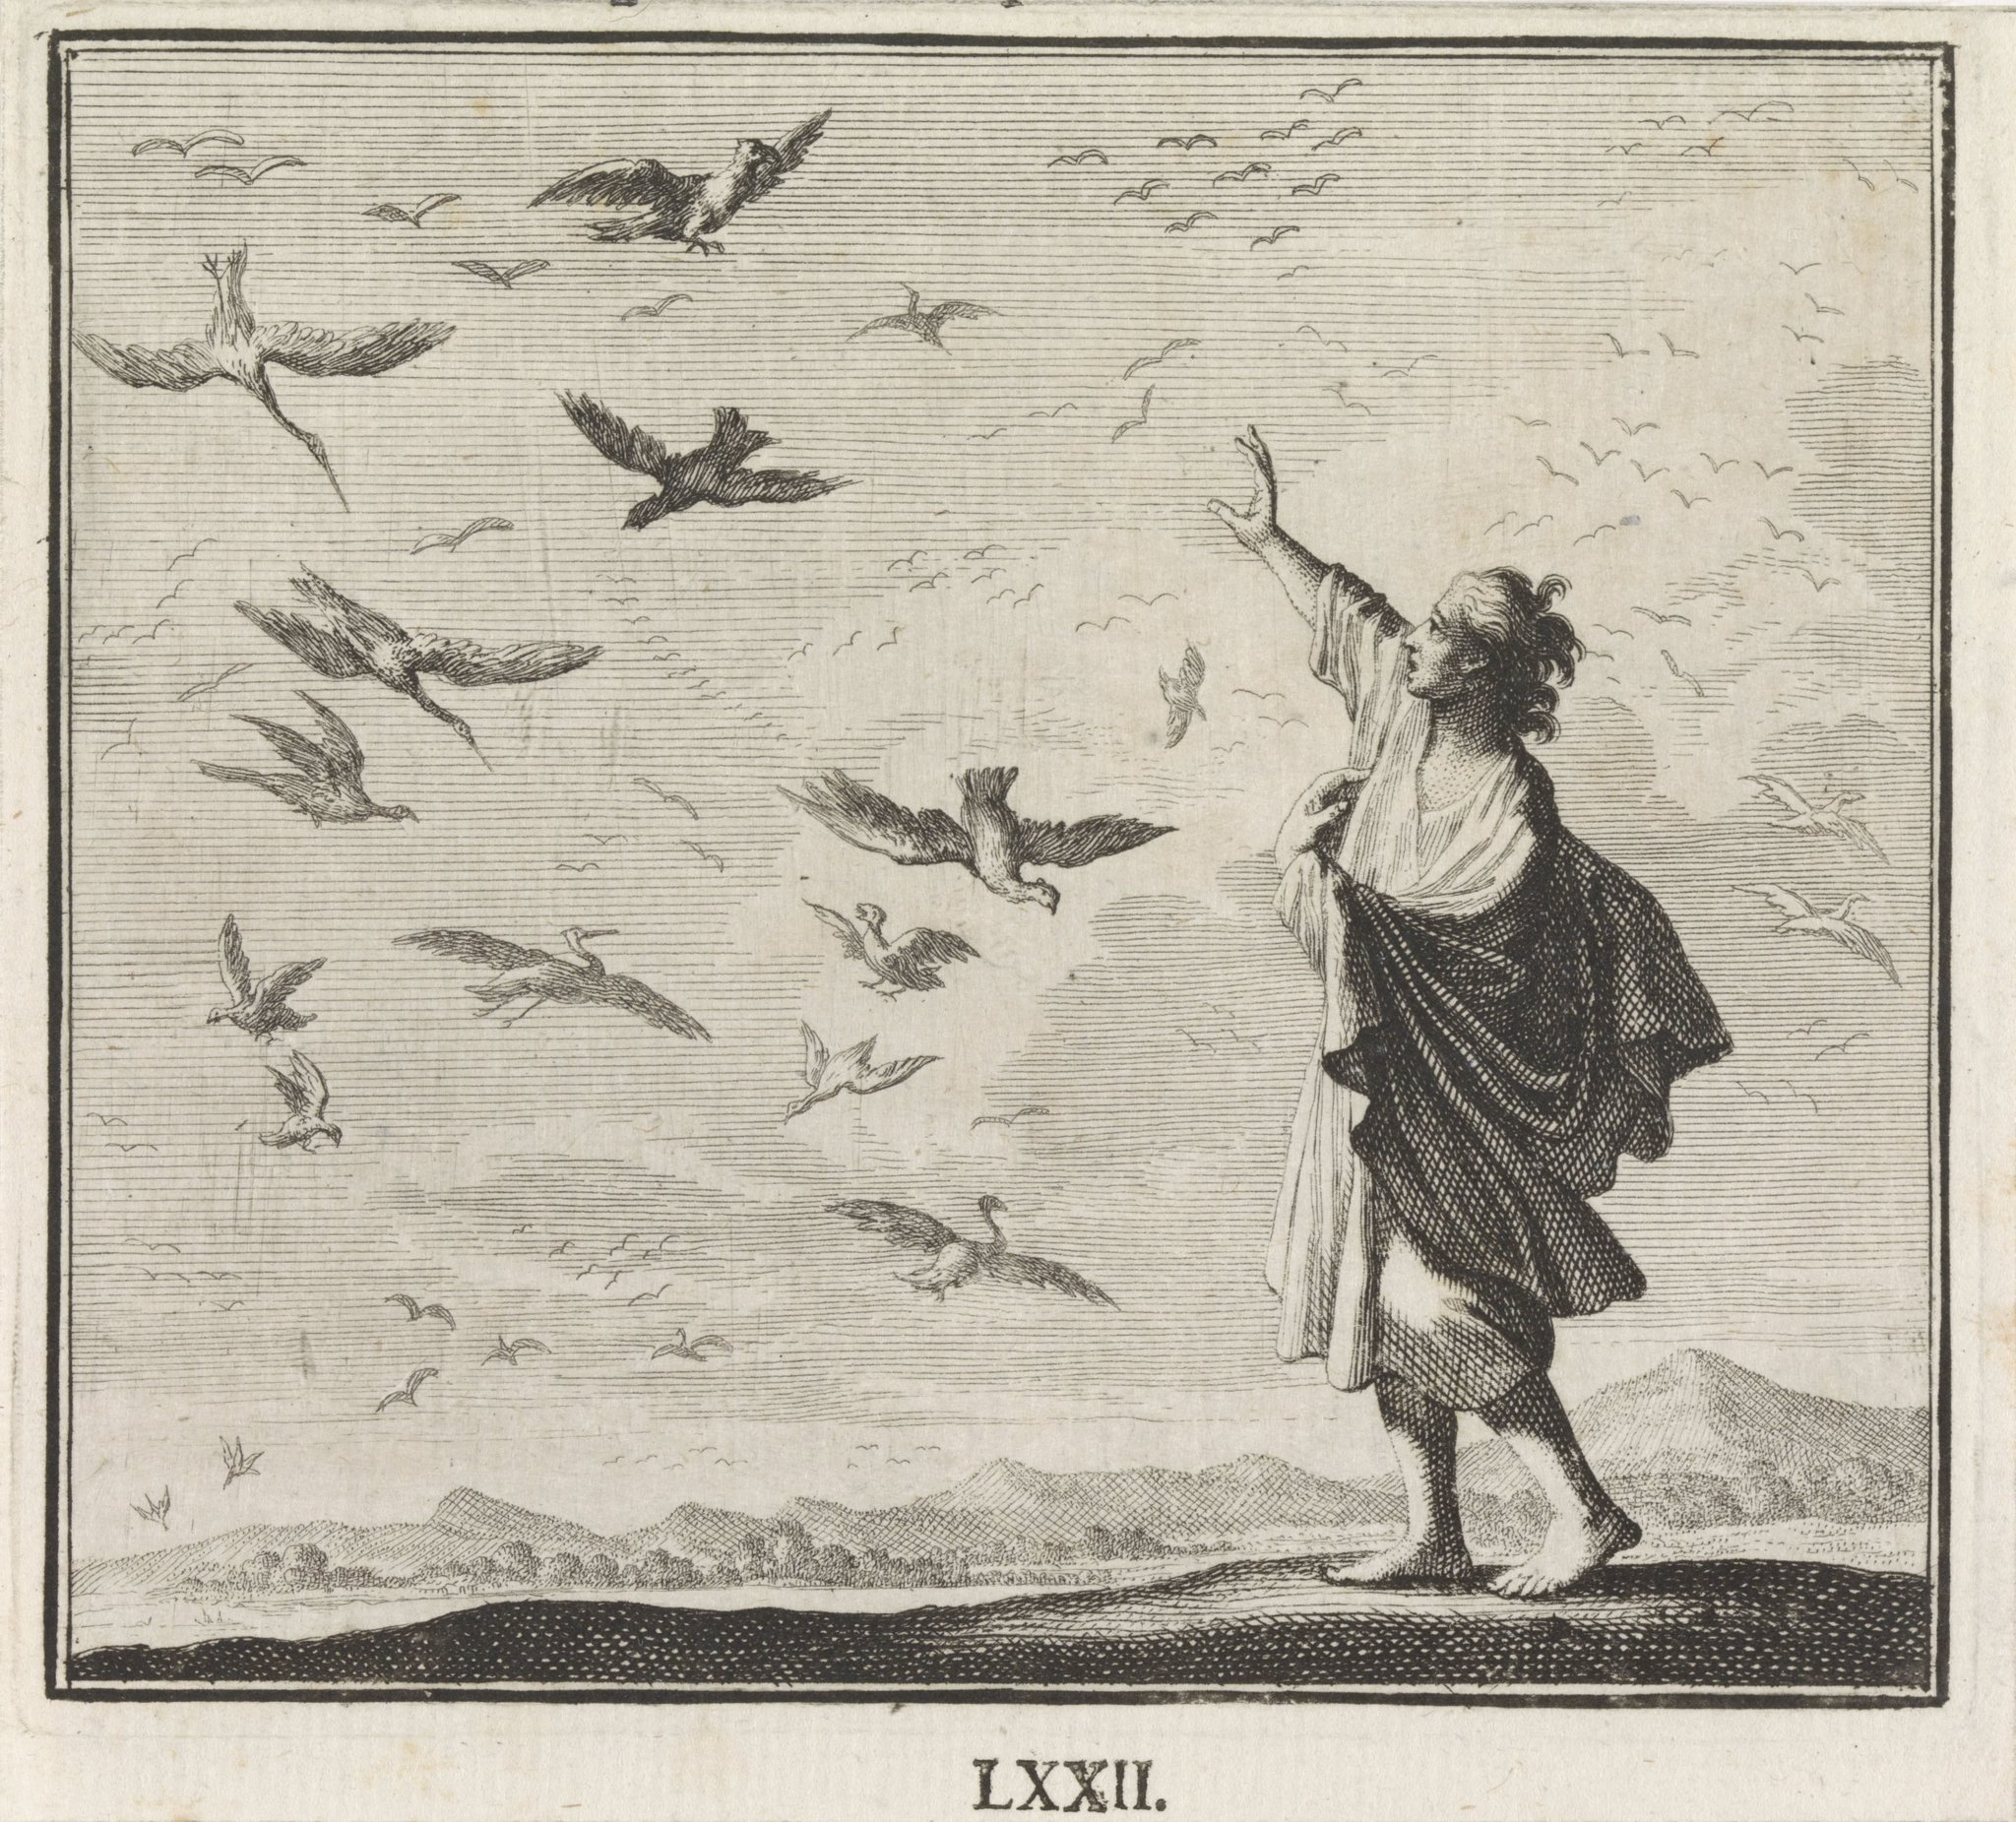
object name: print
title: Embleem: vogels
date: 1695-1705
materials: paper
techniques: etching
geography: nuremberg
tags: birds, abstract ideas and concepts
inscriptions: collector's mark: Lugt 2228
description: Boekillustratie voor Weigel, Christoph. Ethica Naturalis seu Documenta Moralia e Variis rerum Naturalium proprietatibus Virtutum Vitiorumq symbolicis imaginibus collecta. Neurenberg: Christoph Weigel: c. 1700.